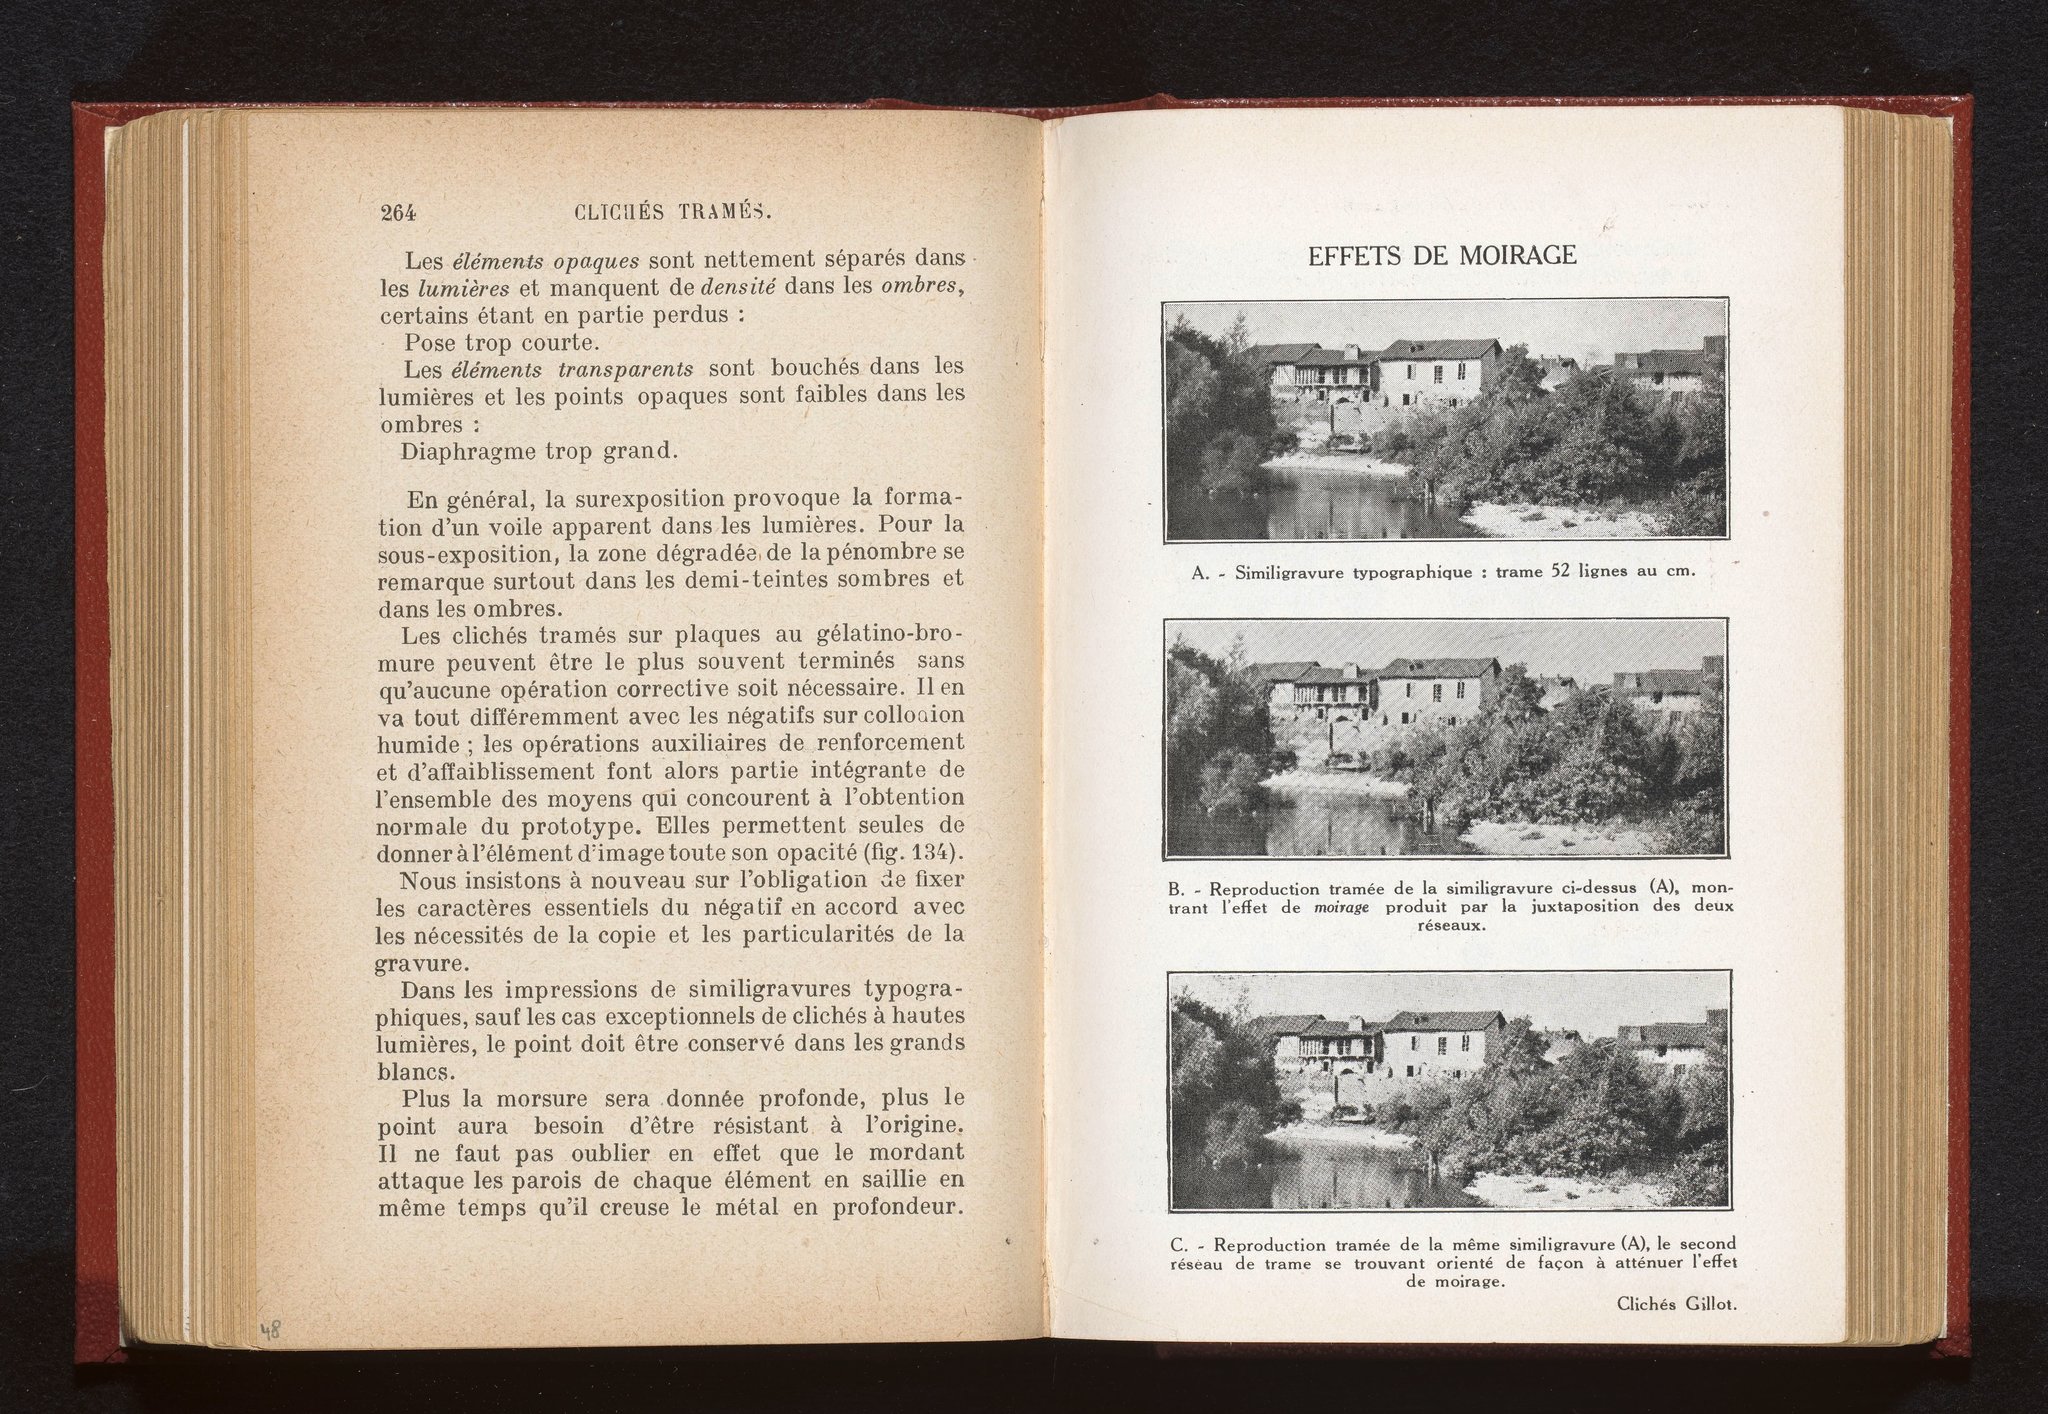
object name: photomechanical print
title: Effets de moirage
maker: Anonymous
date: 1922-1932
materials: paper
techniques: autotype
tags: river, housing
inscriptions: inscription: ‘A. Similigravure typographique : trame 52 lignes au cm. B. Reproduction tramée de la similigravure ci-dessus (A), montrant l'effet de moirage produit par la juxtaposition des deux réseaux. C. Reproduction tramée de la même similigravure (A), le second réseau de trame se trouvant orienté de façon à atténnuer l'effet de moirage.’